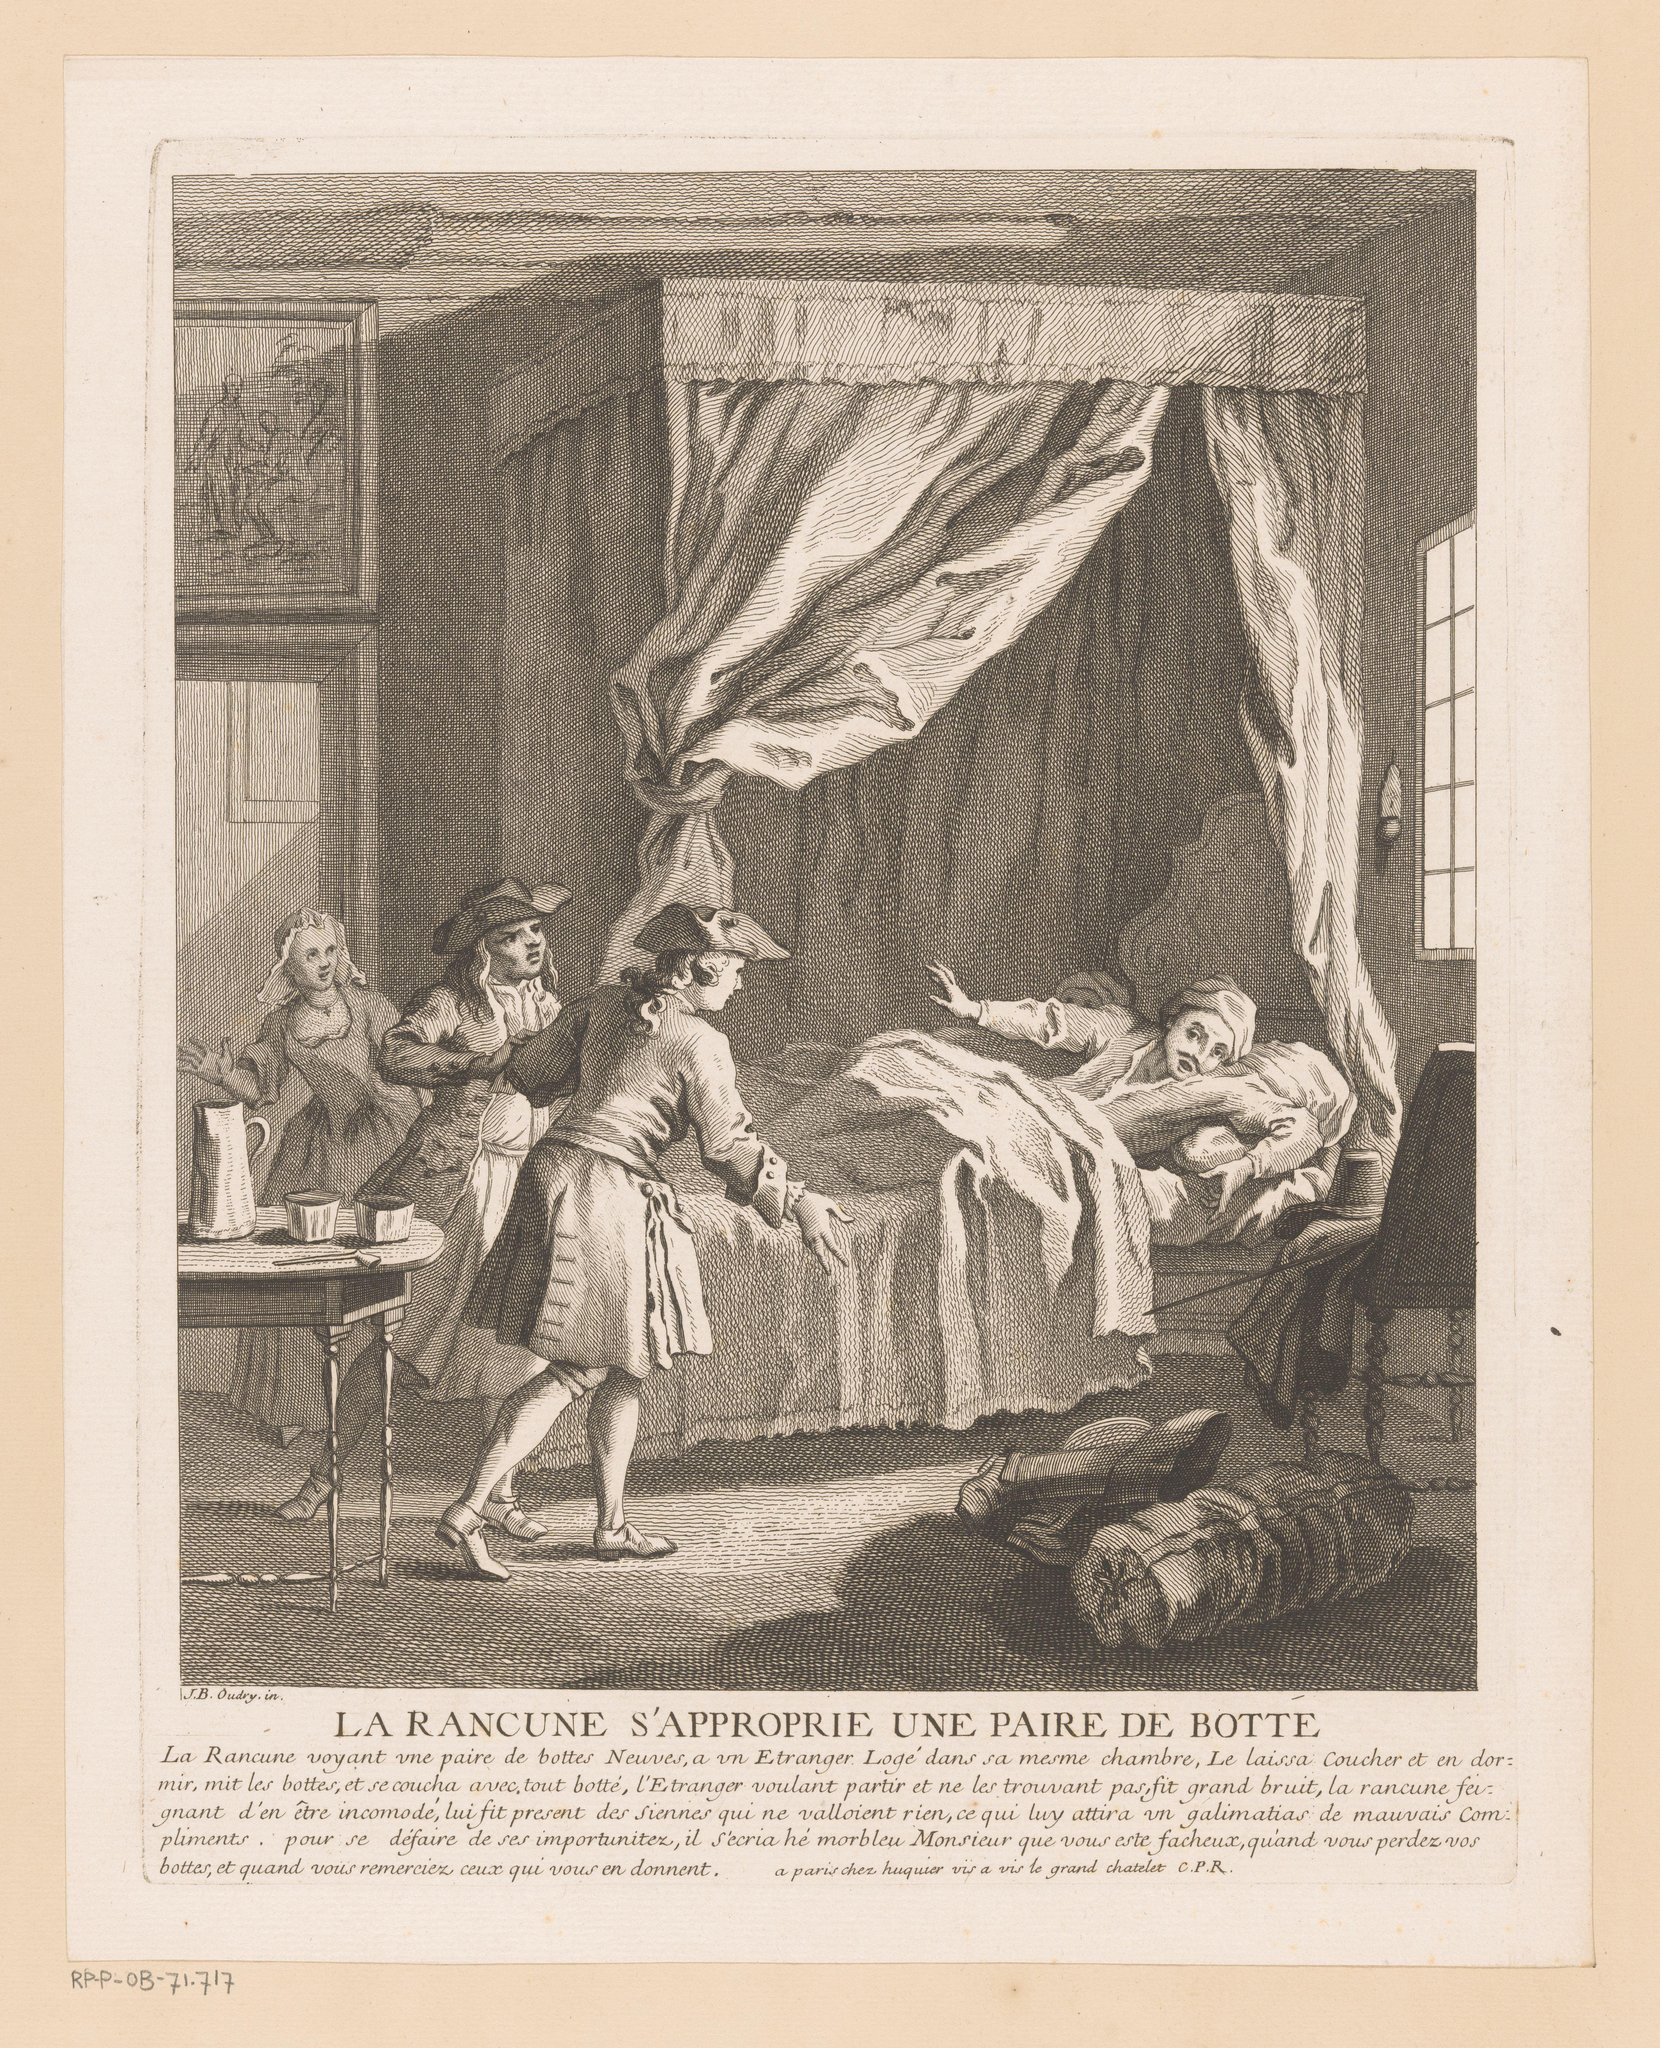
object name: print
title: Ontdekking van gestolen laarzen bij Wrok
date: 1705-1772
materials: paper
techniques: engraving, etching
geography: france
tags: (scarron, roman comique) specific works of literature (with author, title), boots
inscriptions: collector's mark: Lugt 240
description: Wrok schrikt wakker als twee mannen het gestolen paar laarzen op zijn kamer vinden.